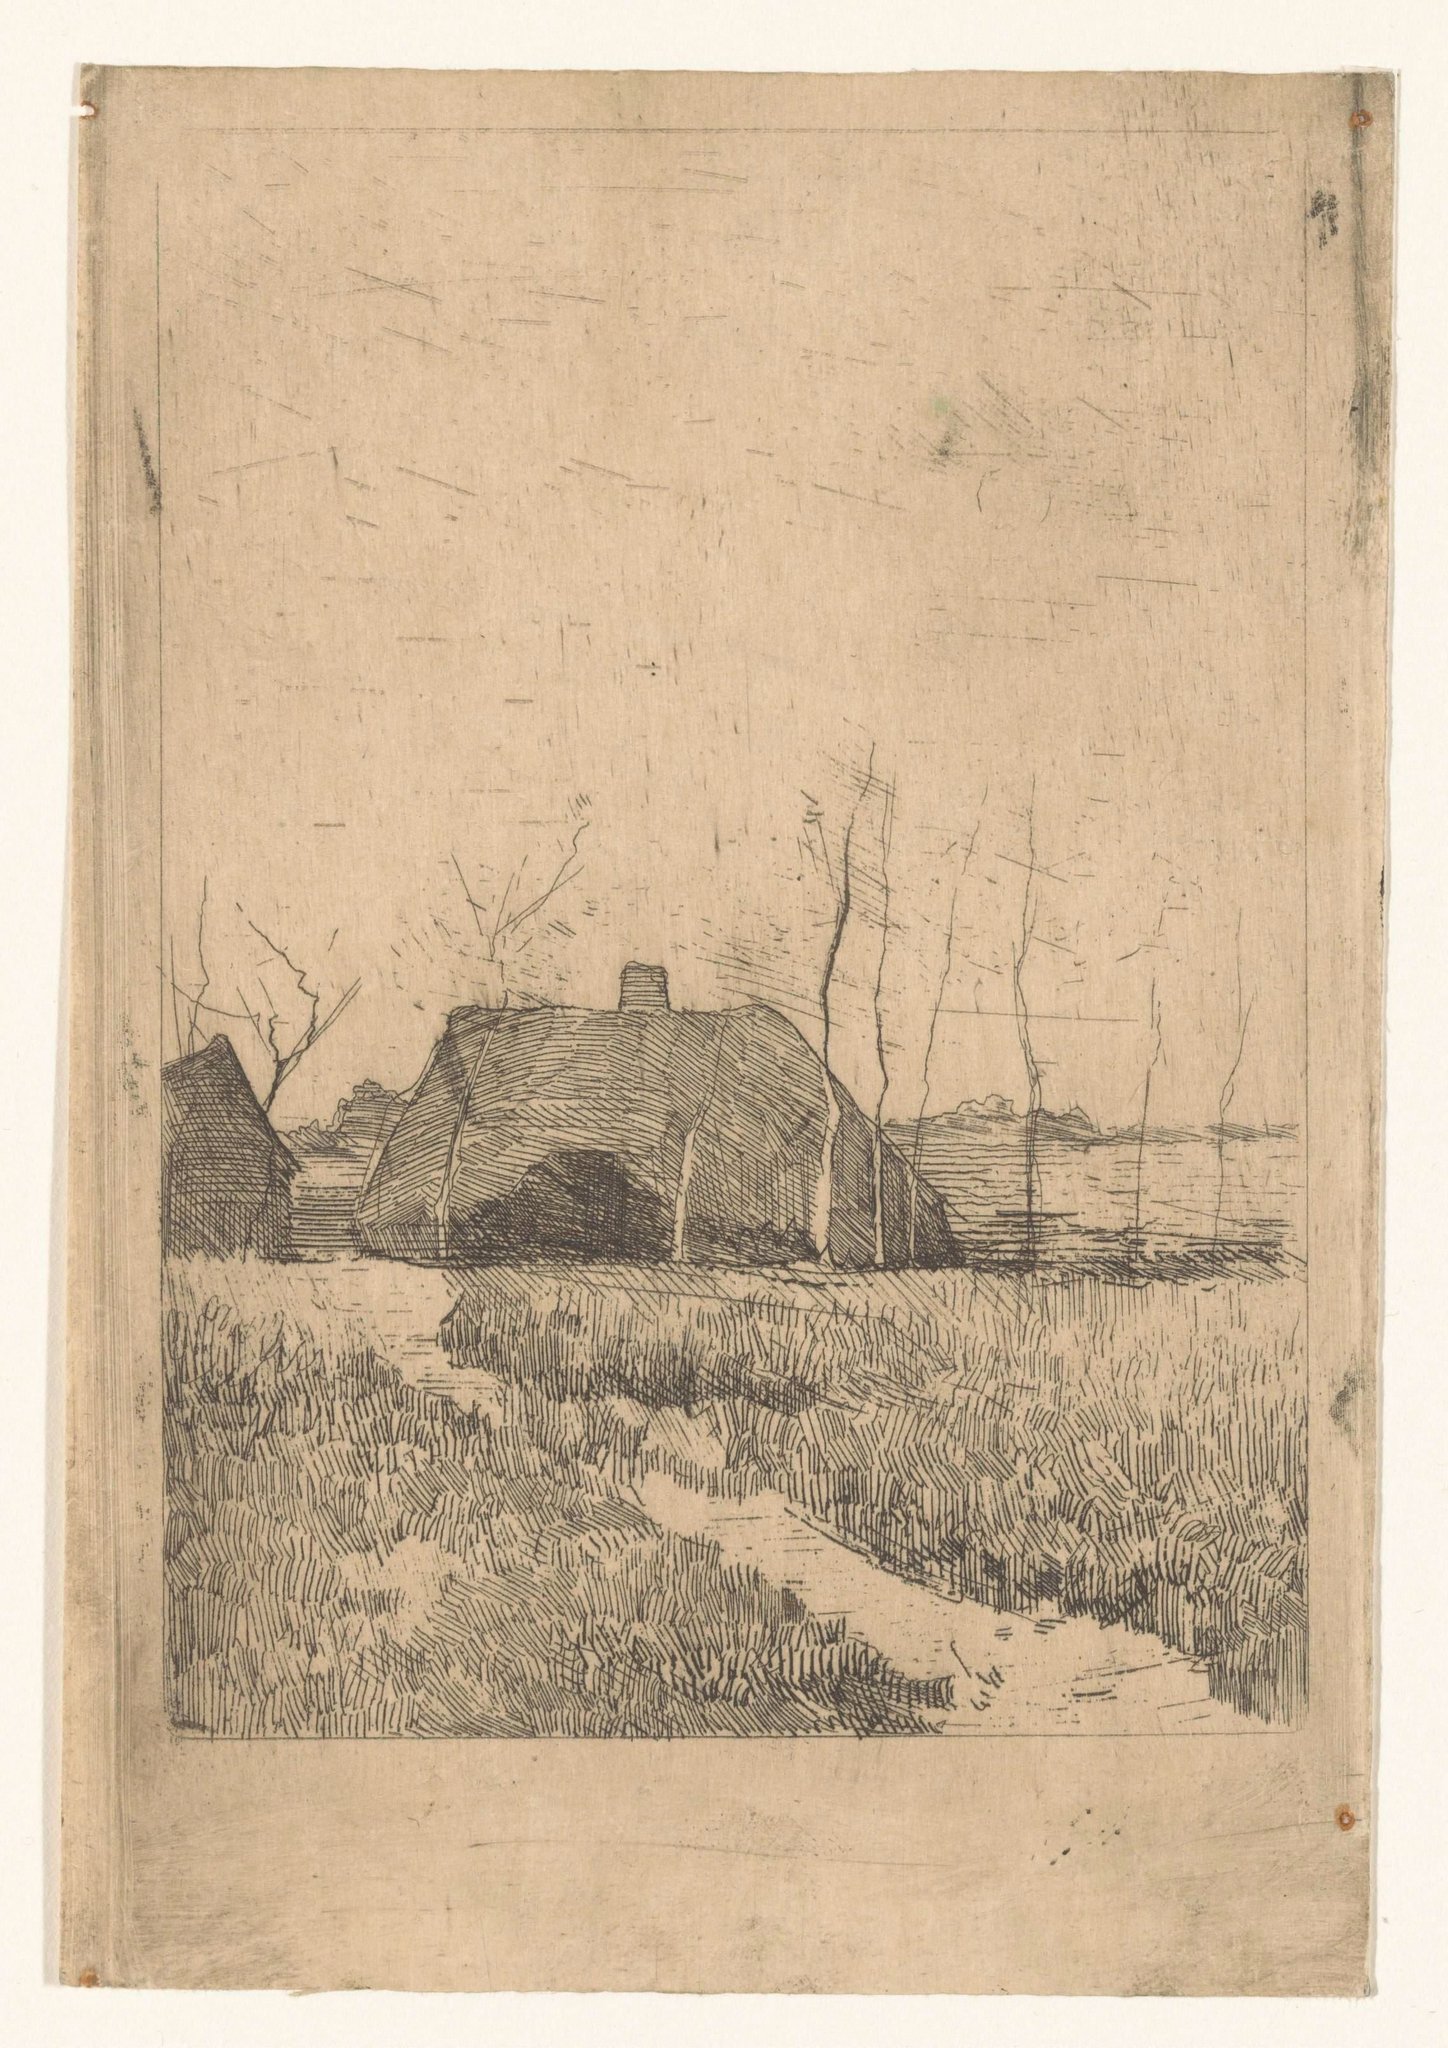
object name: print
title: Boerderij bij avond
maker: willem witsen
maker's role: draughtsman, painter, print maker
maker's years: 1860-1923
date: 1882-1884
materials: chalk, paper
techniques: etching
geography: amsterdam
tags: plantation, farm (building)